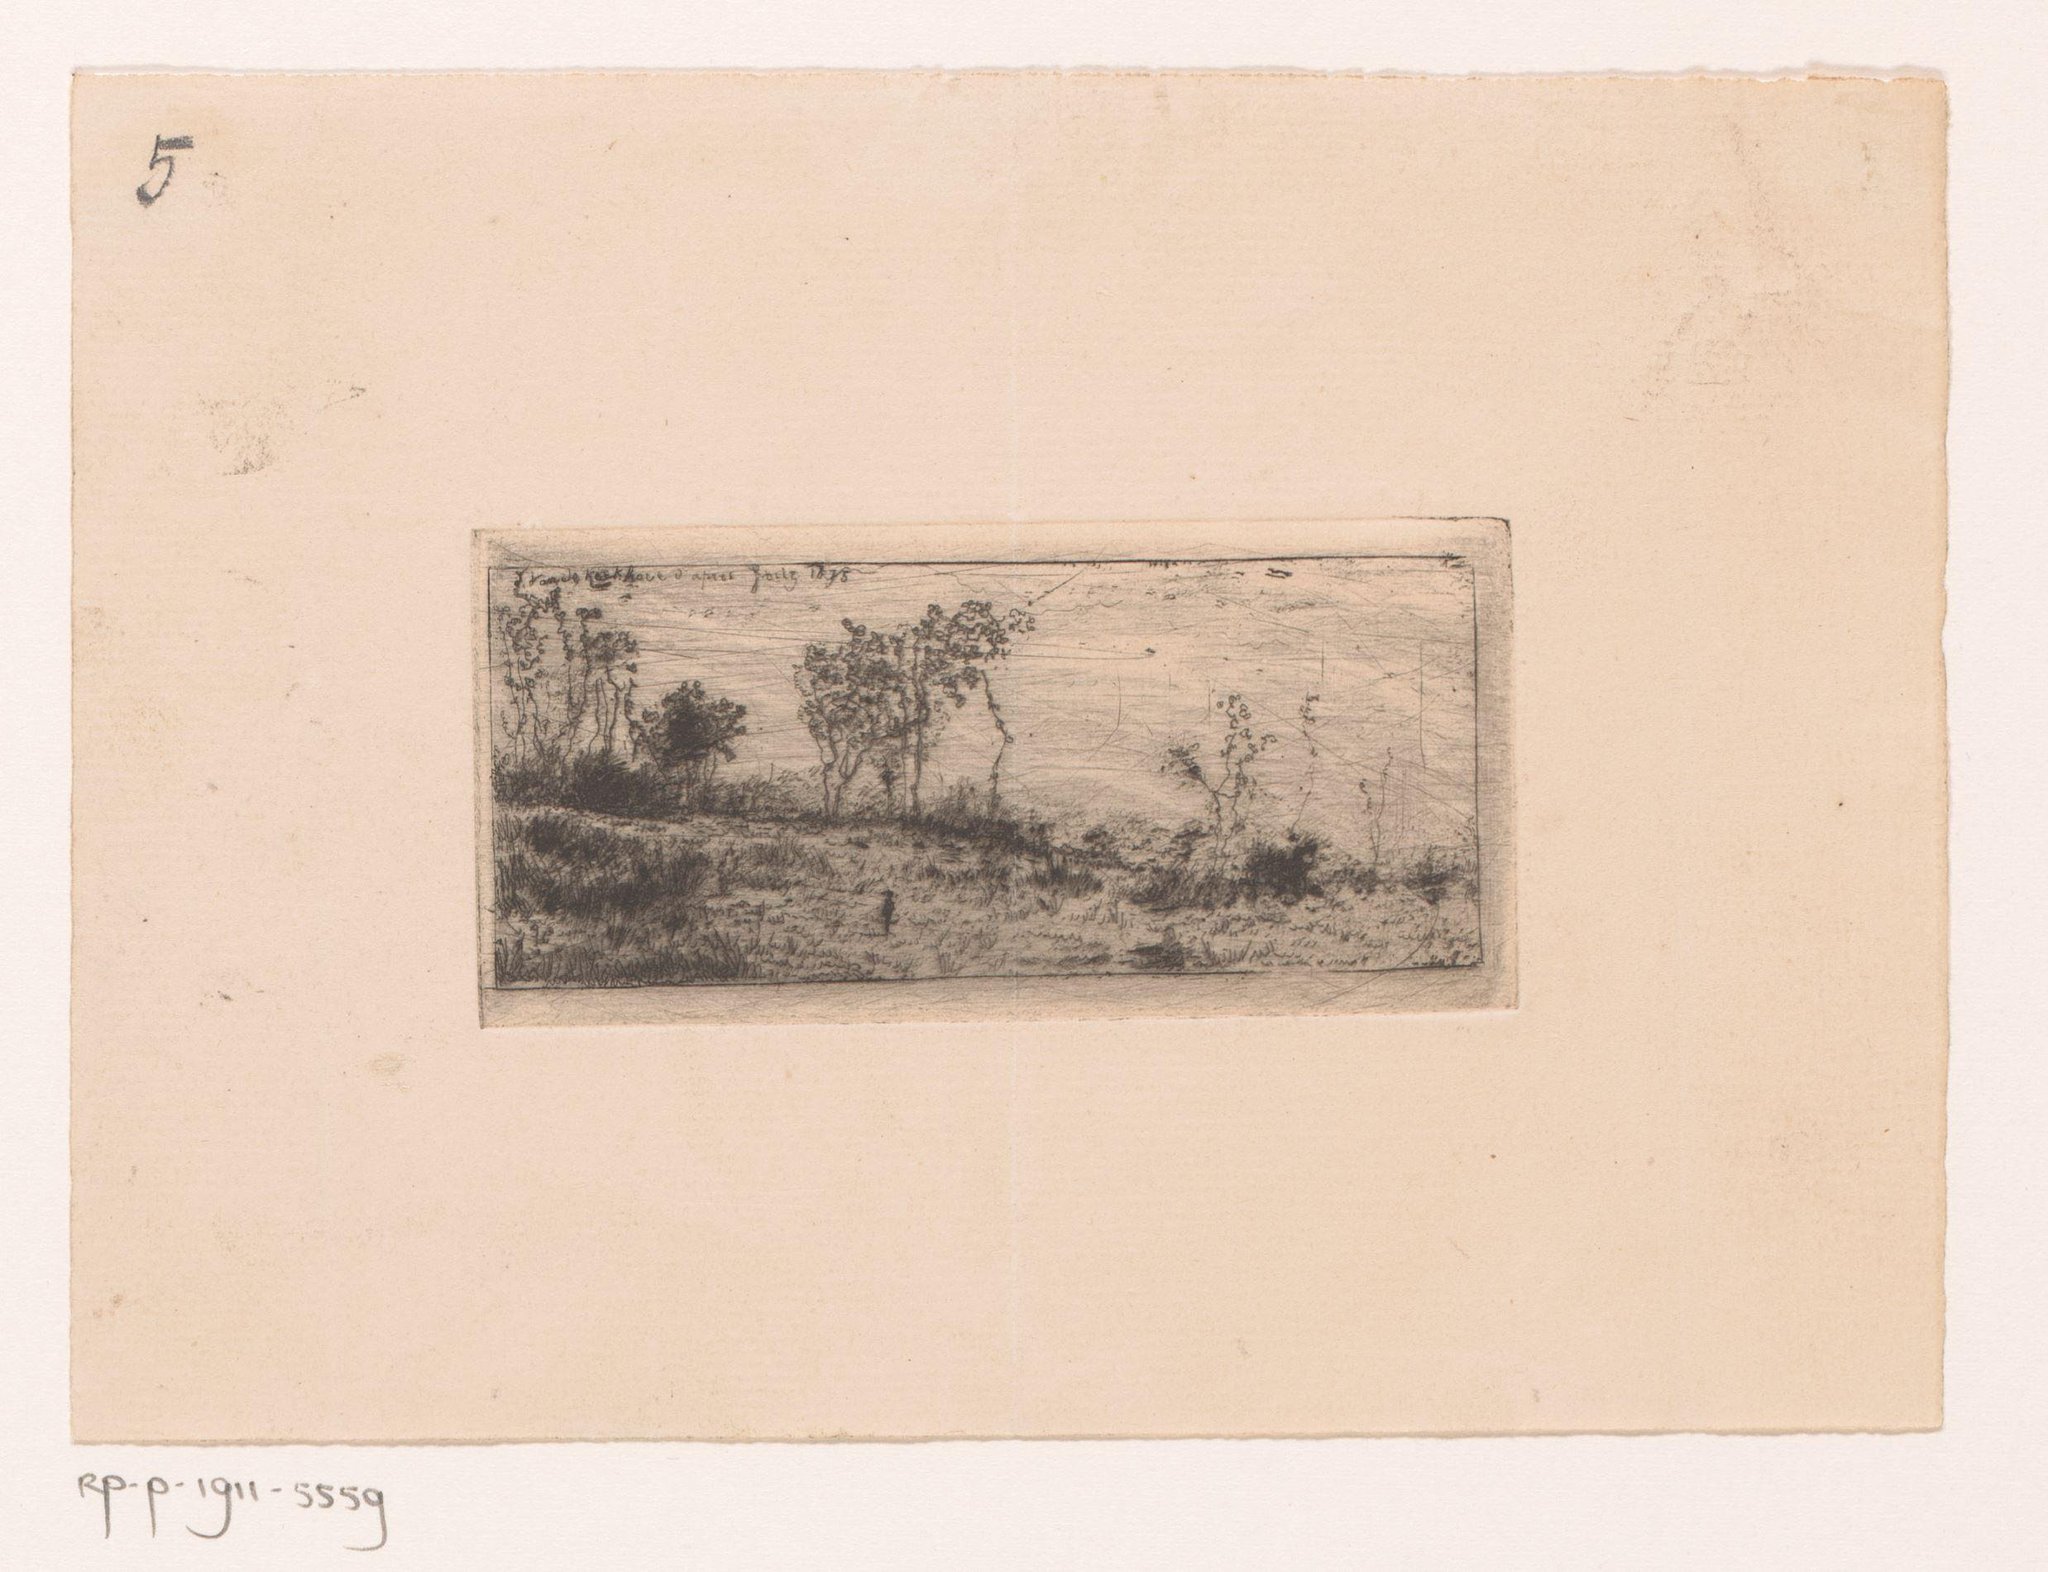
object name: print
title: Landschap met bomen en klein figuur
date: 1875-1876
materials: paper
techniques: etching, intaglio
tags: landscapes in the temperate zone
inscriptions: collector's mark: Lugt 2228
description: De etsen naar de schilderijen van Frédéric Van de Kerkhove werden na zijn dood door zijn vader en zuster gemaakt en uitgegeven in twee reeksen. De eerste werd in 1877 uitgegeven door het Journal des Beaux-Arts et de la Littérature: Cahier de 25 Eaux-fortes d'après Frédéric van de Kerkhove, gravées par son père et sa sœur. De tweede reeks van 126 etsen werd, ook in 1877, in Parijs uitgegeven bij A. Lévy onder de titel Cent eaux-fortes gravées par J. Van de Kerkhove d'après les tableaux de Frédéric Van de Kerkhove, mort en 1873 à l'âge de 10 ans et 11 mois.